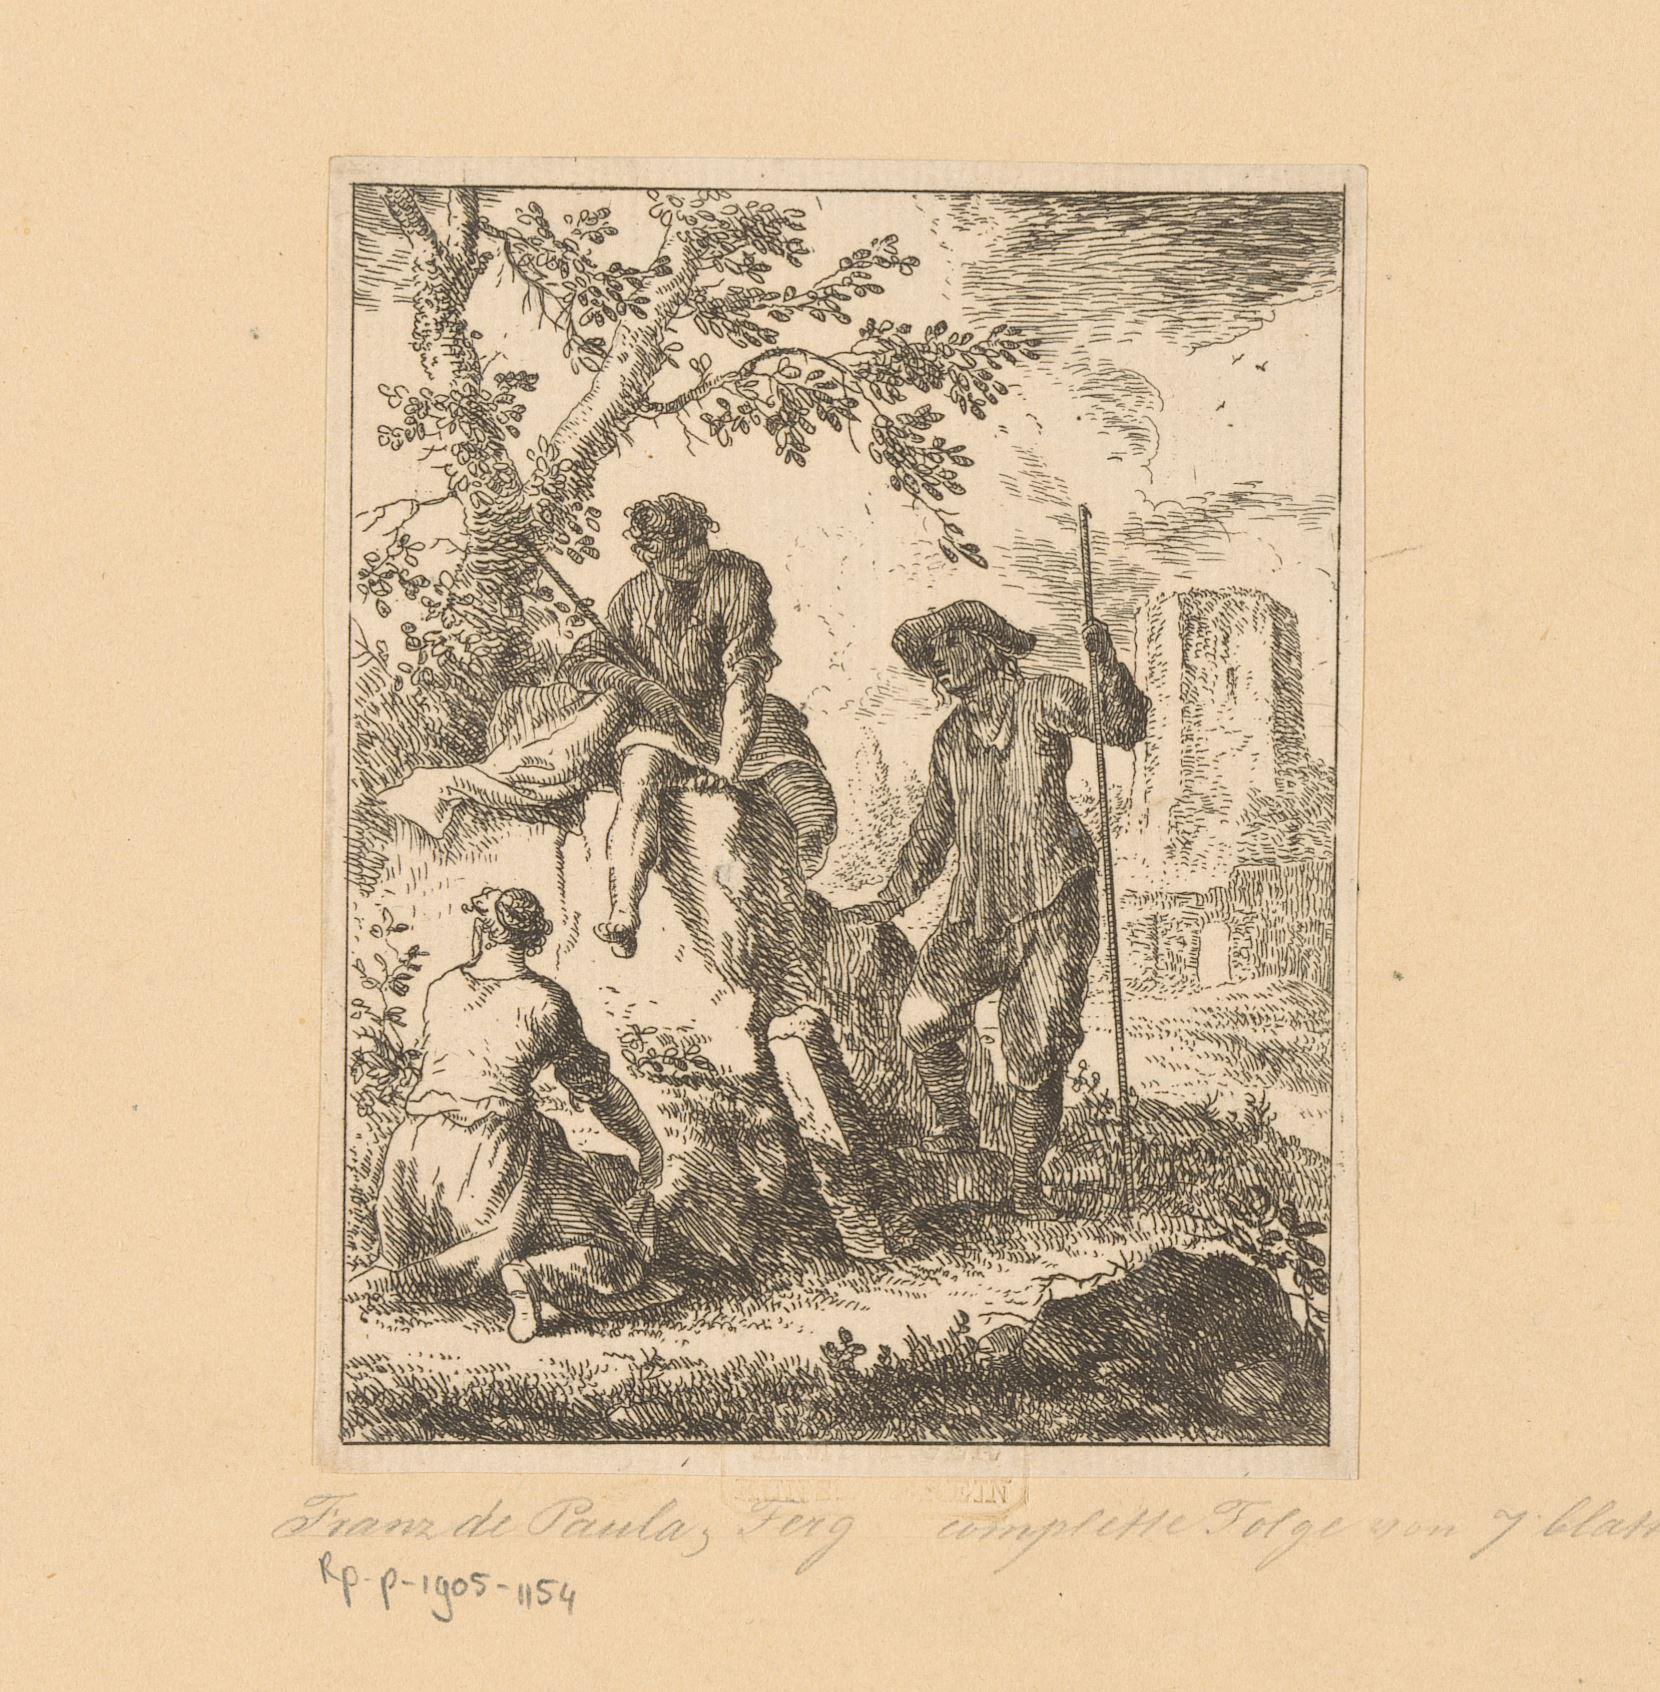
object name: print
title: Drie herders rustend in een landschap met ruïnes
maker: franz de paula ferg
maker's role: draughtsman, painter, print maker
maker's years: 1689-1740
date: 1699-1740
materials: paper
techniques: etching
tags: herding, herdsman, herdswoman, shepherd, shepherdess, cowherd, etc., landscape with ruins, resting - bb - out of doors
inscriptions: collector's mark: Lugt 2228, collector's mark: Lugt 1236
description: Onderdeel van een serie van zeven prenten.